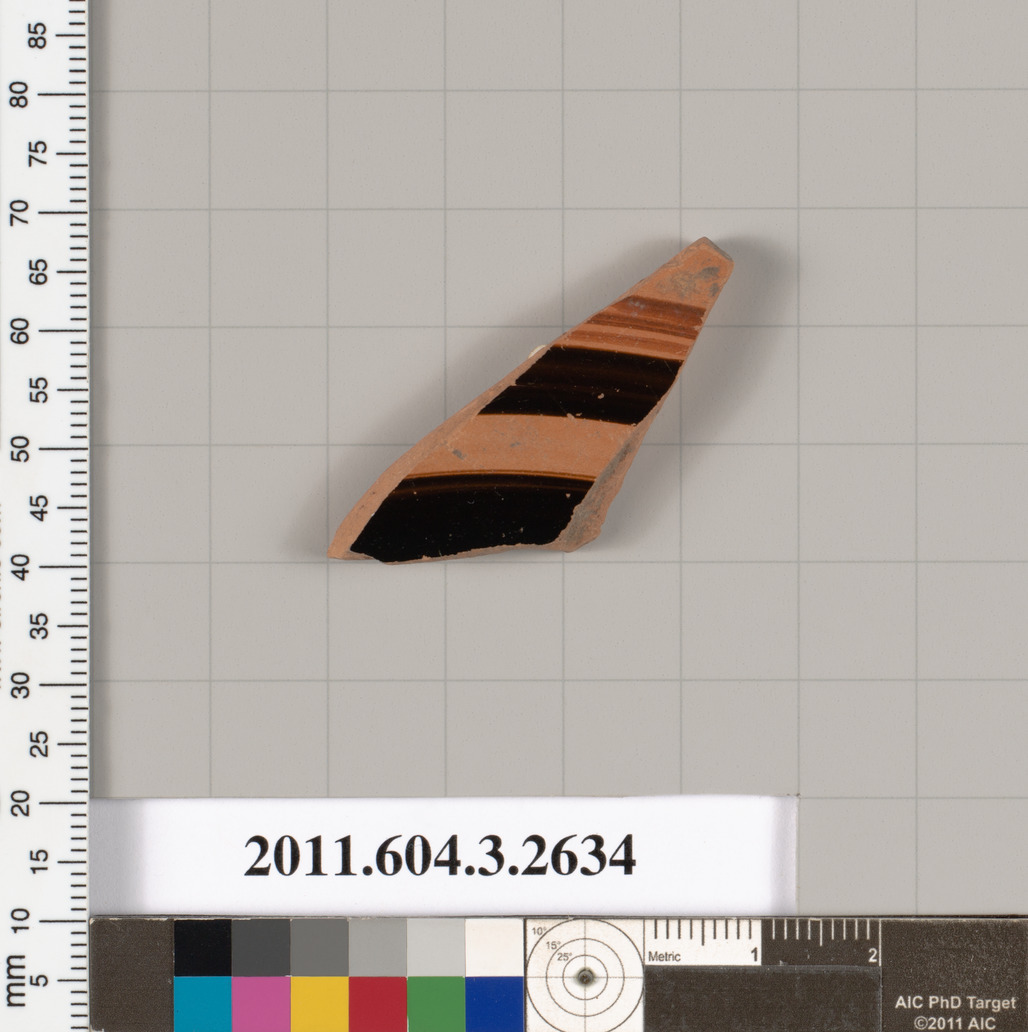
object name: kylix fragment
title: Terracotta fragment of a kylix (drinking cup)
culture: greek, attic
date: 600-401 BCE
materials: terracotta